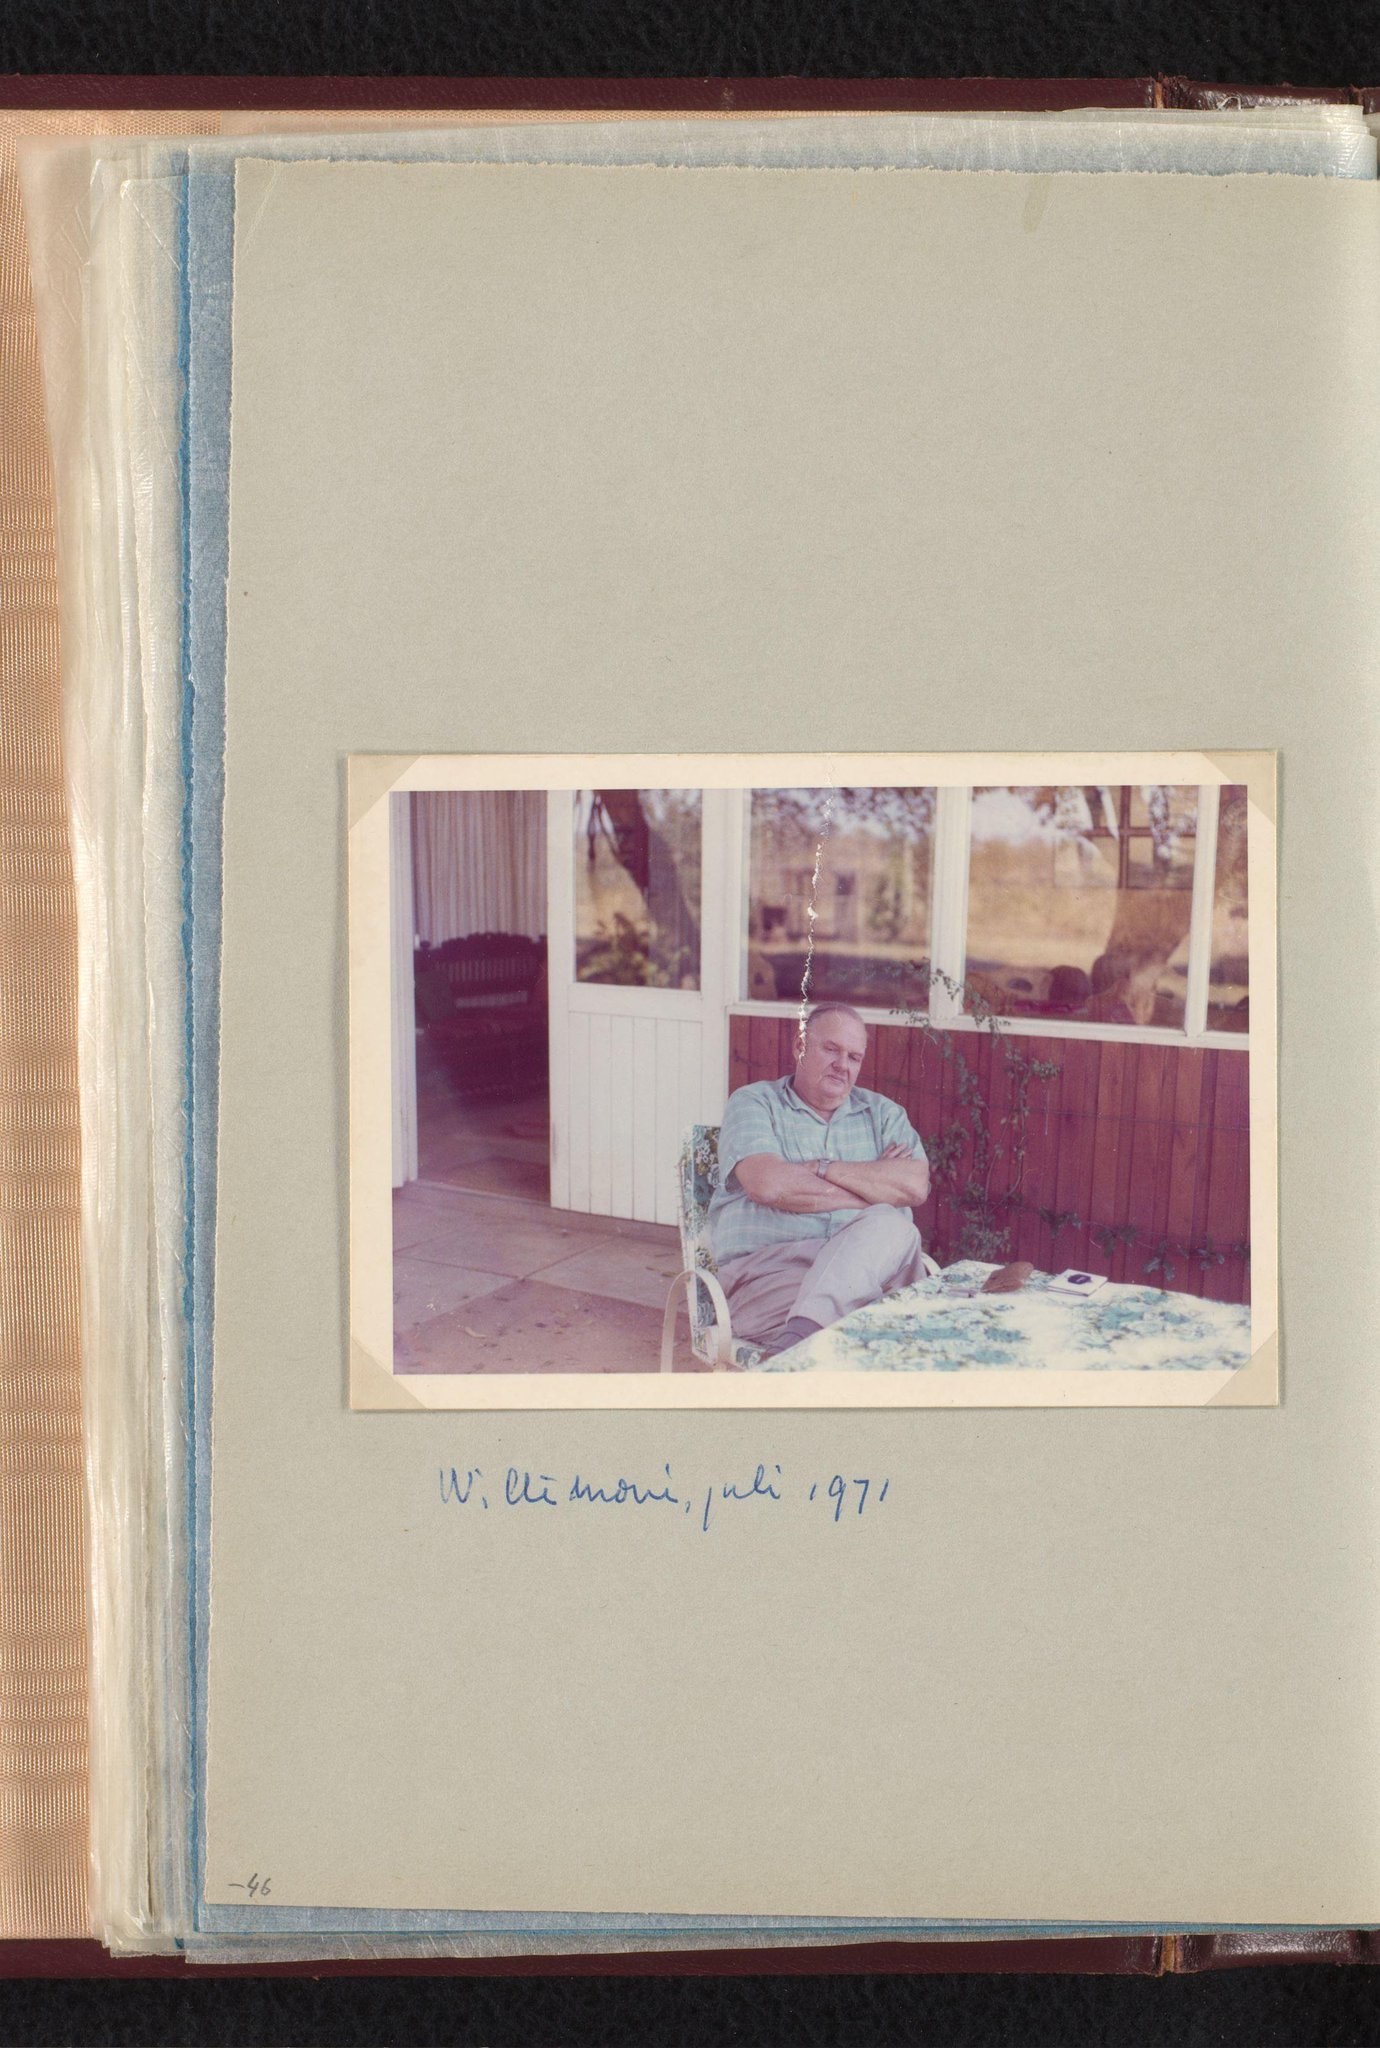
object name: photograph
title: Willimoni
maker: willem jacob van den berg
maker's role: boer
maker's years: 1902-1983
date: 1907-1971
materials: paper, cardboard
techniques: chromogenic print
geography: shewasaulu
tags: amsterdam, willem jacob van den berg, civic architecture; edifices; dwellings